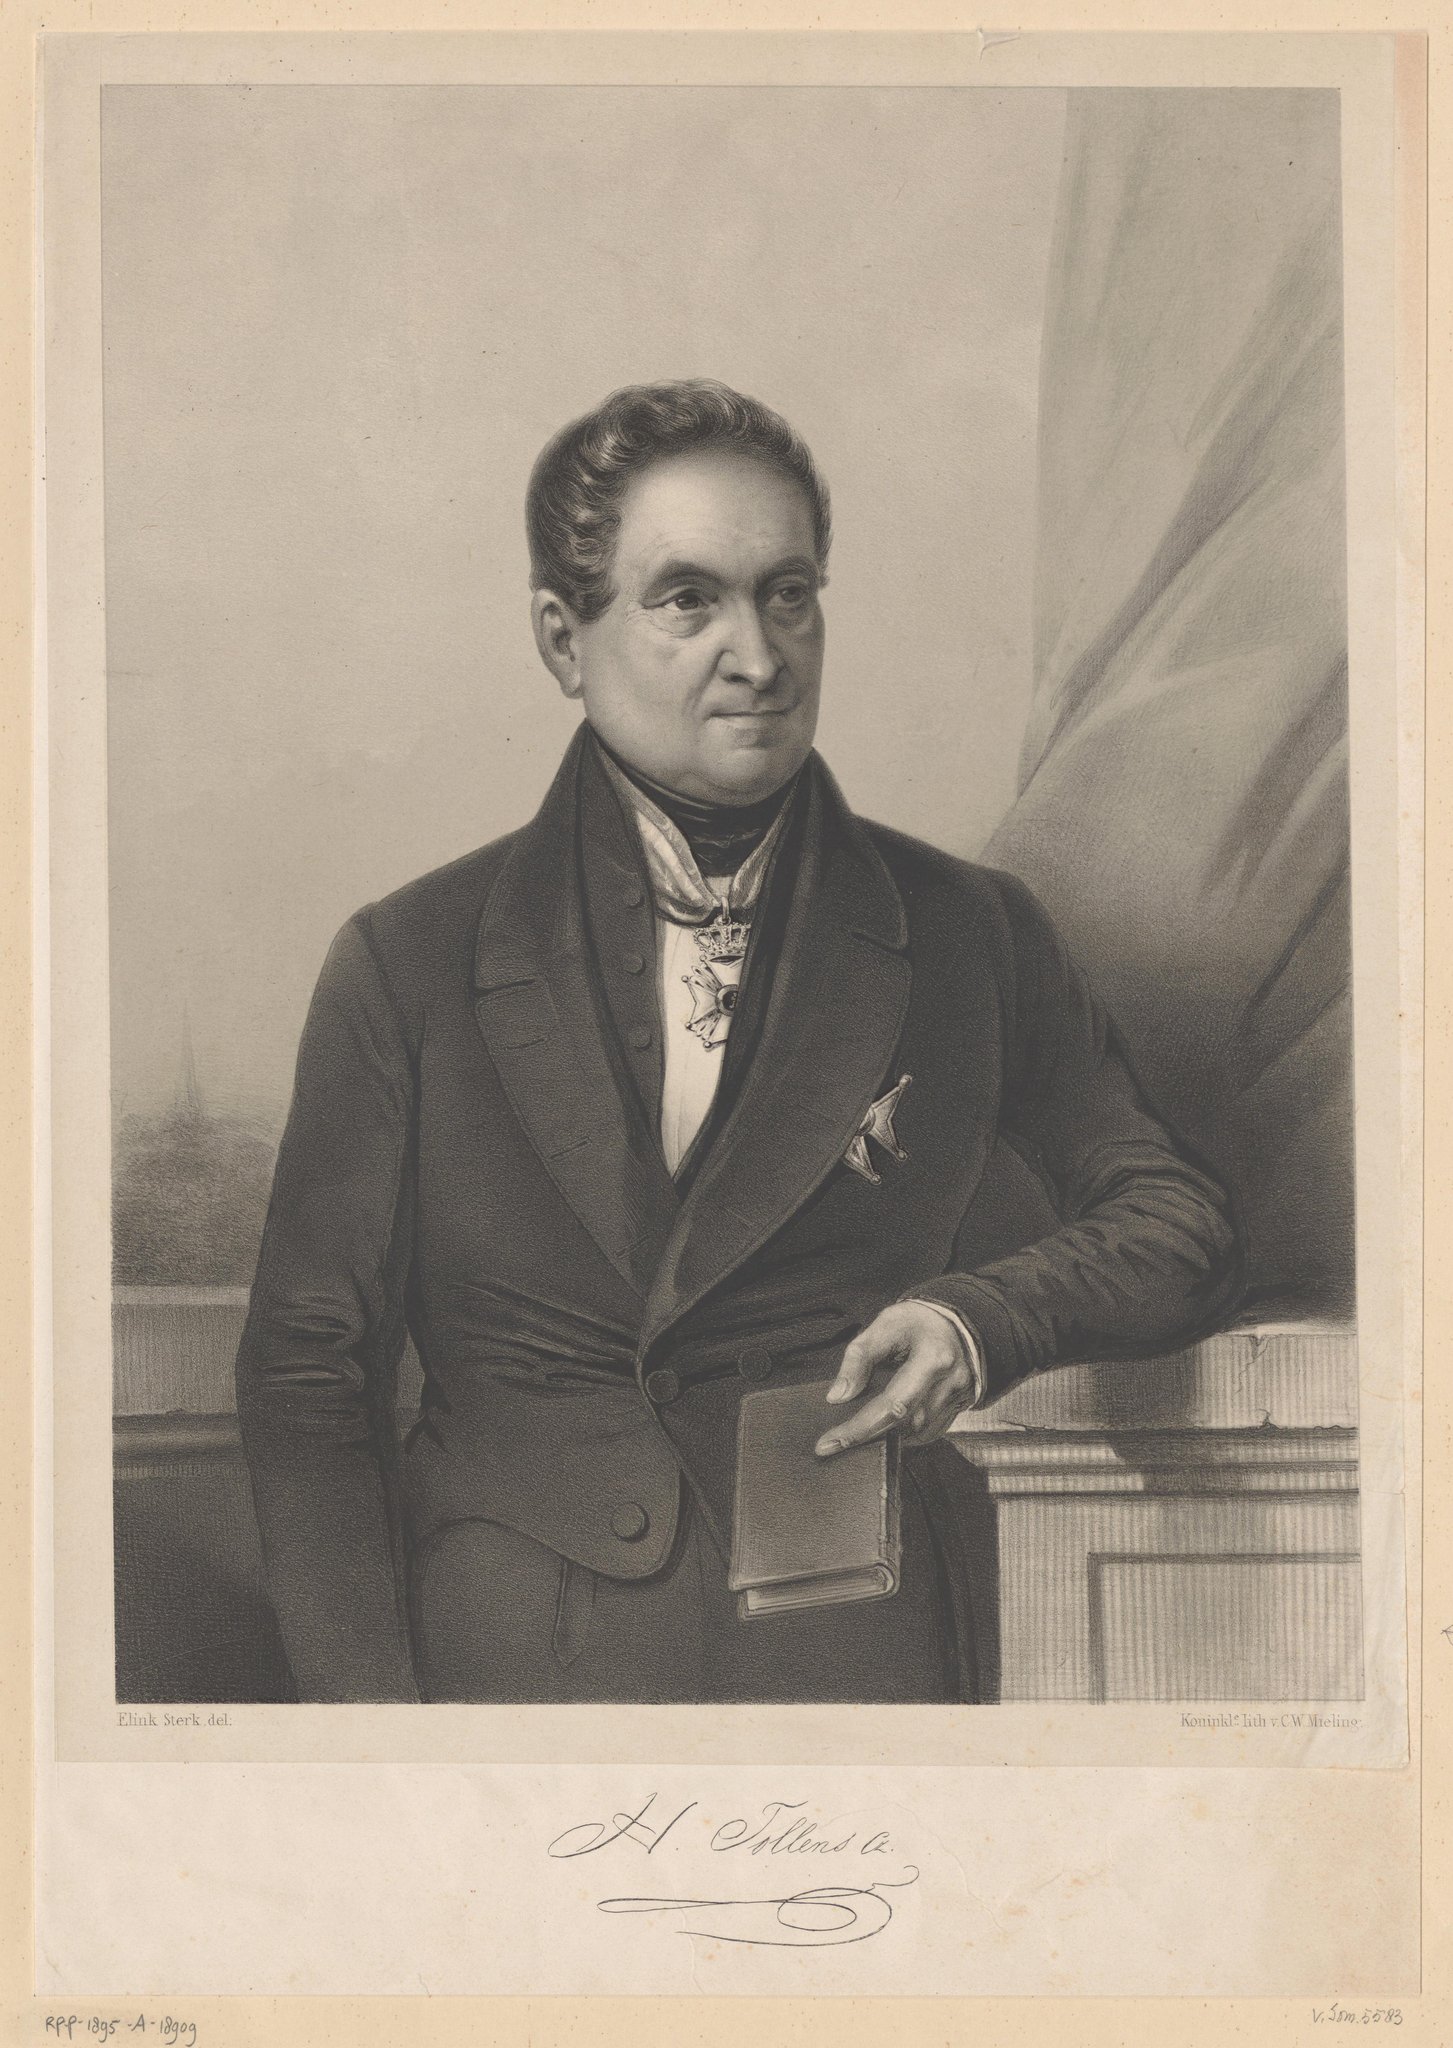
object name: print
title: Portret van Hendrik Tollens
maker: carl wilhelm mieling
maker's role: print maker, printer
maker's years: 1815-1903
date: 1839-1871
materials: paper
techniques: tone lithography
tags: rotterdam, hendrik tollens, adult man, historical persons, book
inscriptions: collector's mark: Lugt 2228